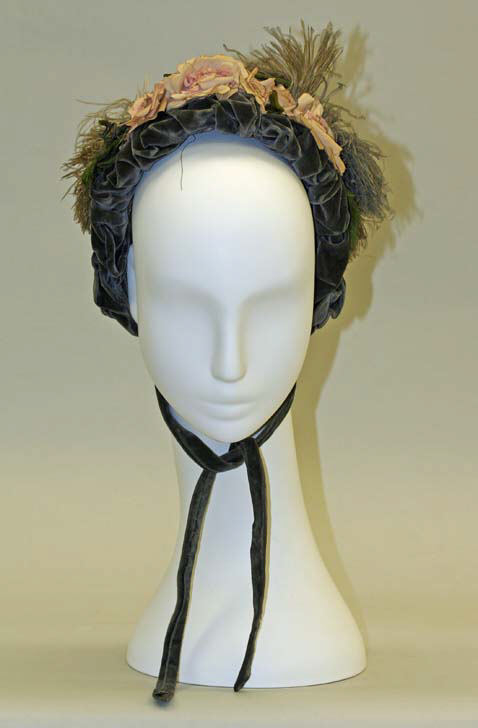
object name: bonnet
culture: american or european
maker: r.h. stearns company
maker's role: department store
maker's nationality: american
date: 1880-1889